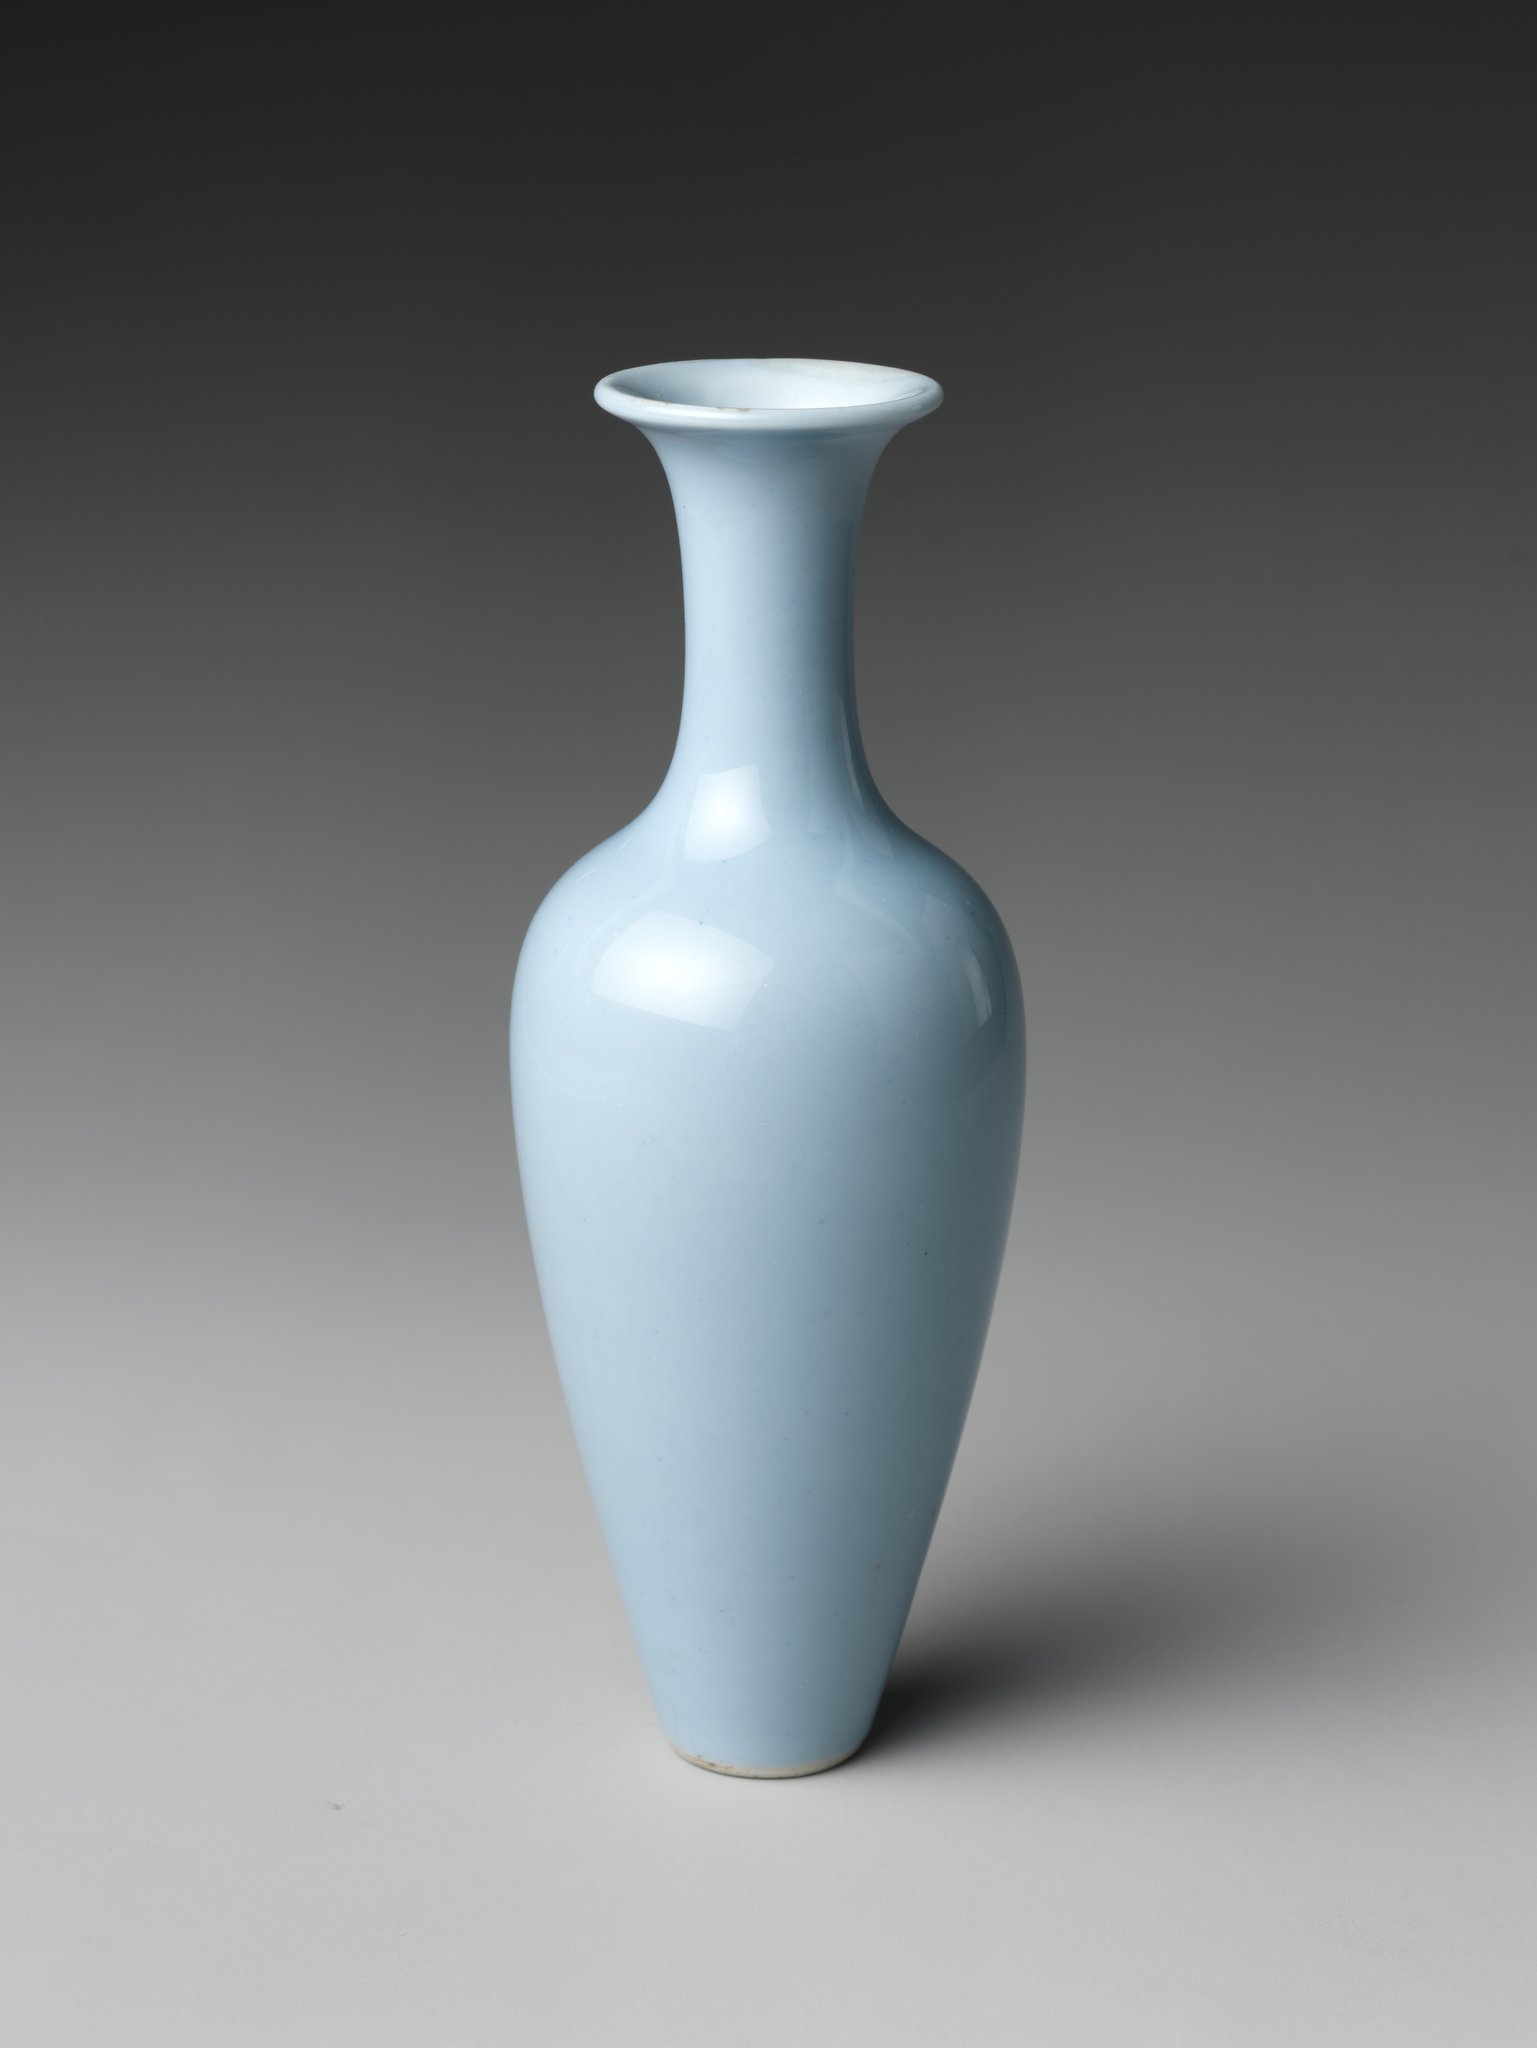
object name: vase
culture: chinese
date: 1678-1688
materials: glaze, porcelain